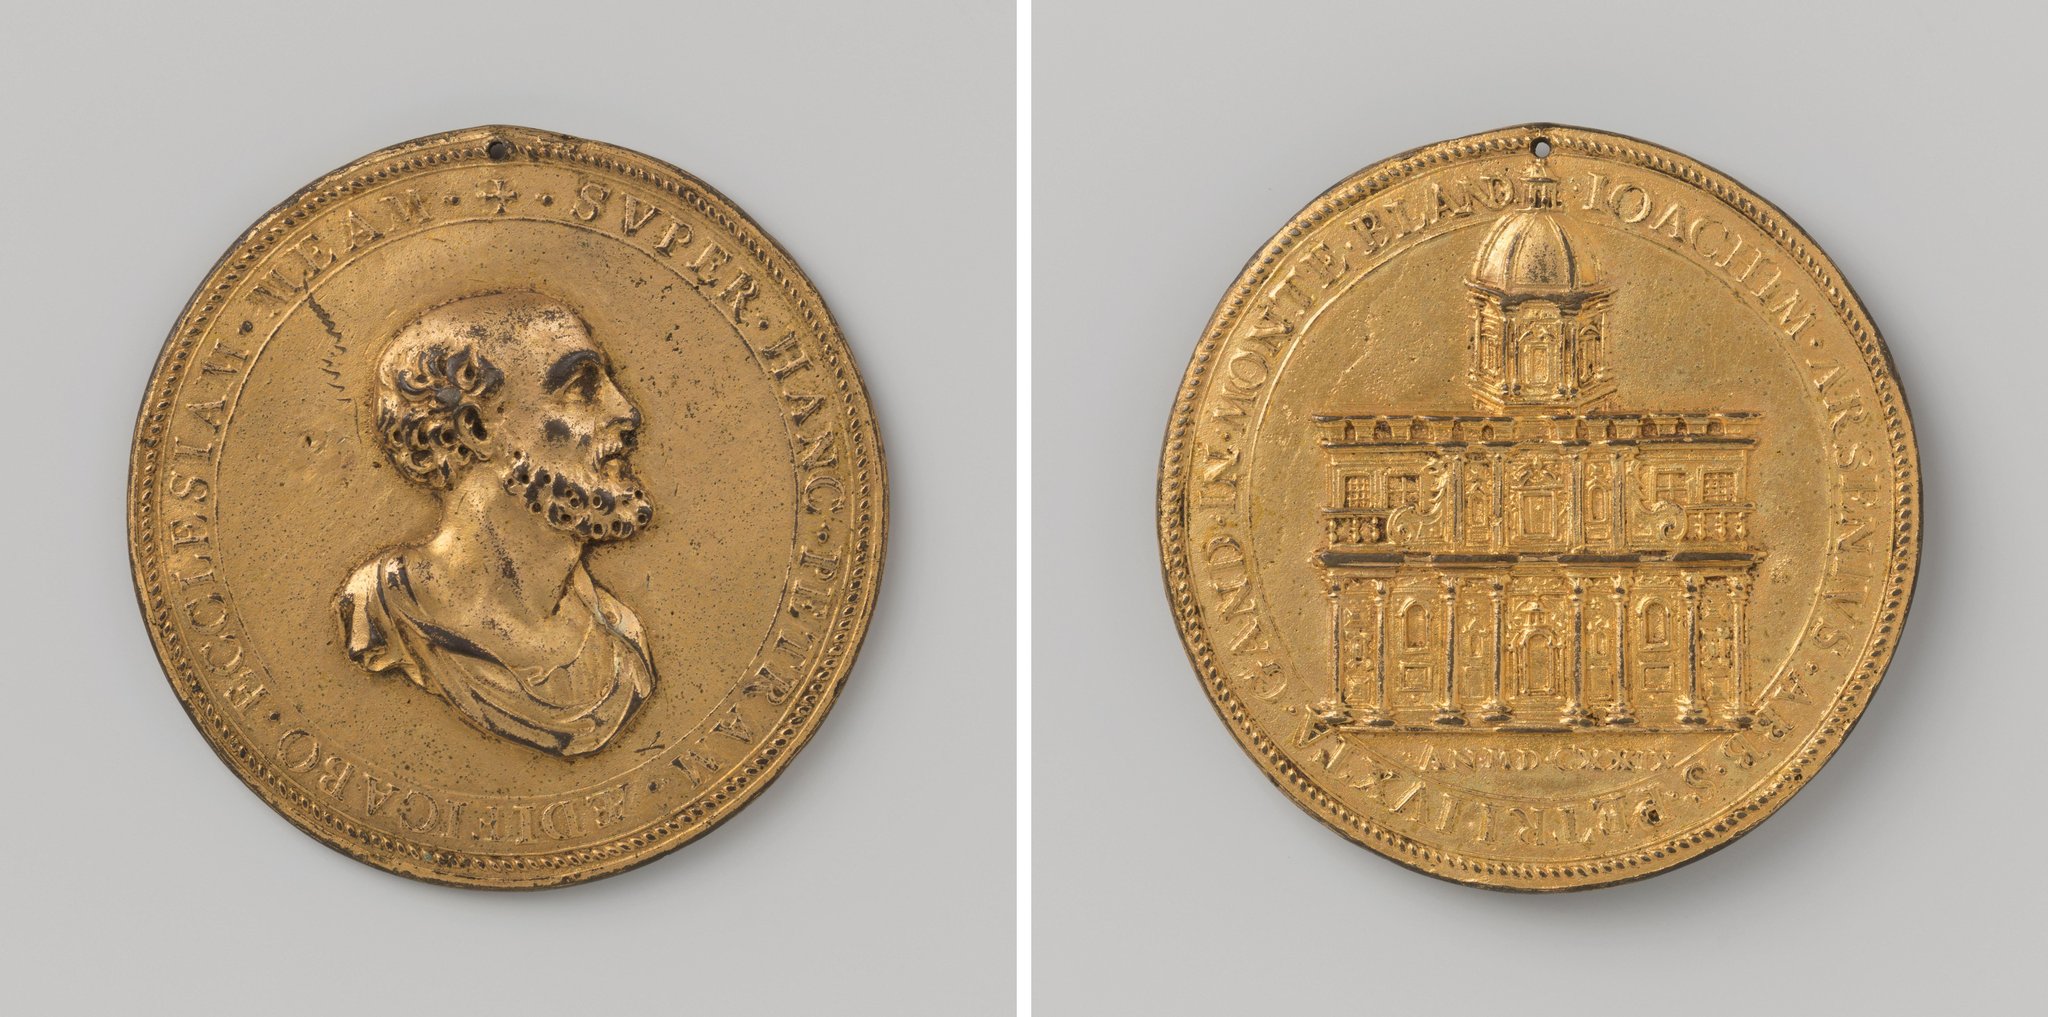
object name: history medal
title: Joachim Aarsens, abt en stichter van het St. Pietersklooster te Gent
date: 1629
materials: silver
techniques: gilding, striking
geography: antwerp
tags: ghent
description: Zilveren penning met gat erin. Voorzijde: borststuk man binnen omschrift. Keerzijde: klooster boven jaartal binnen omschrift